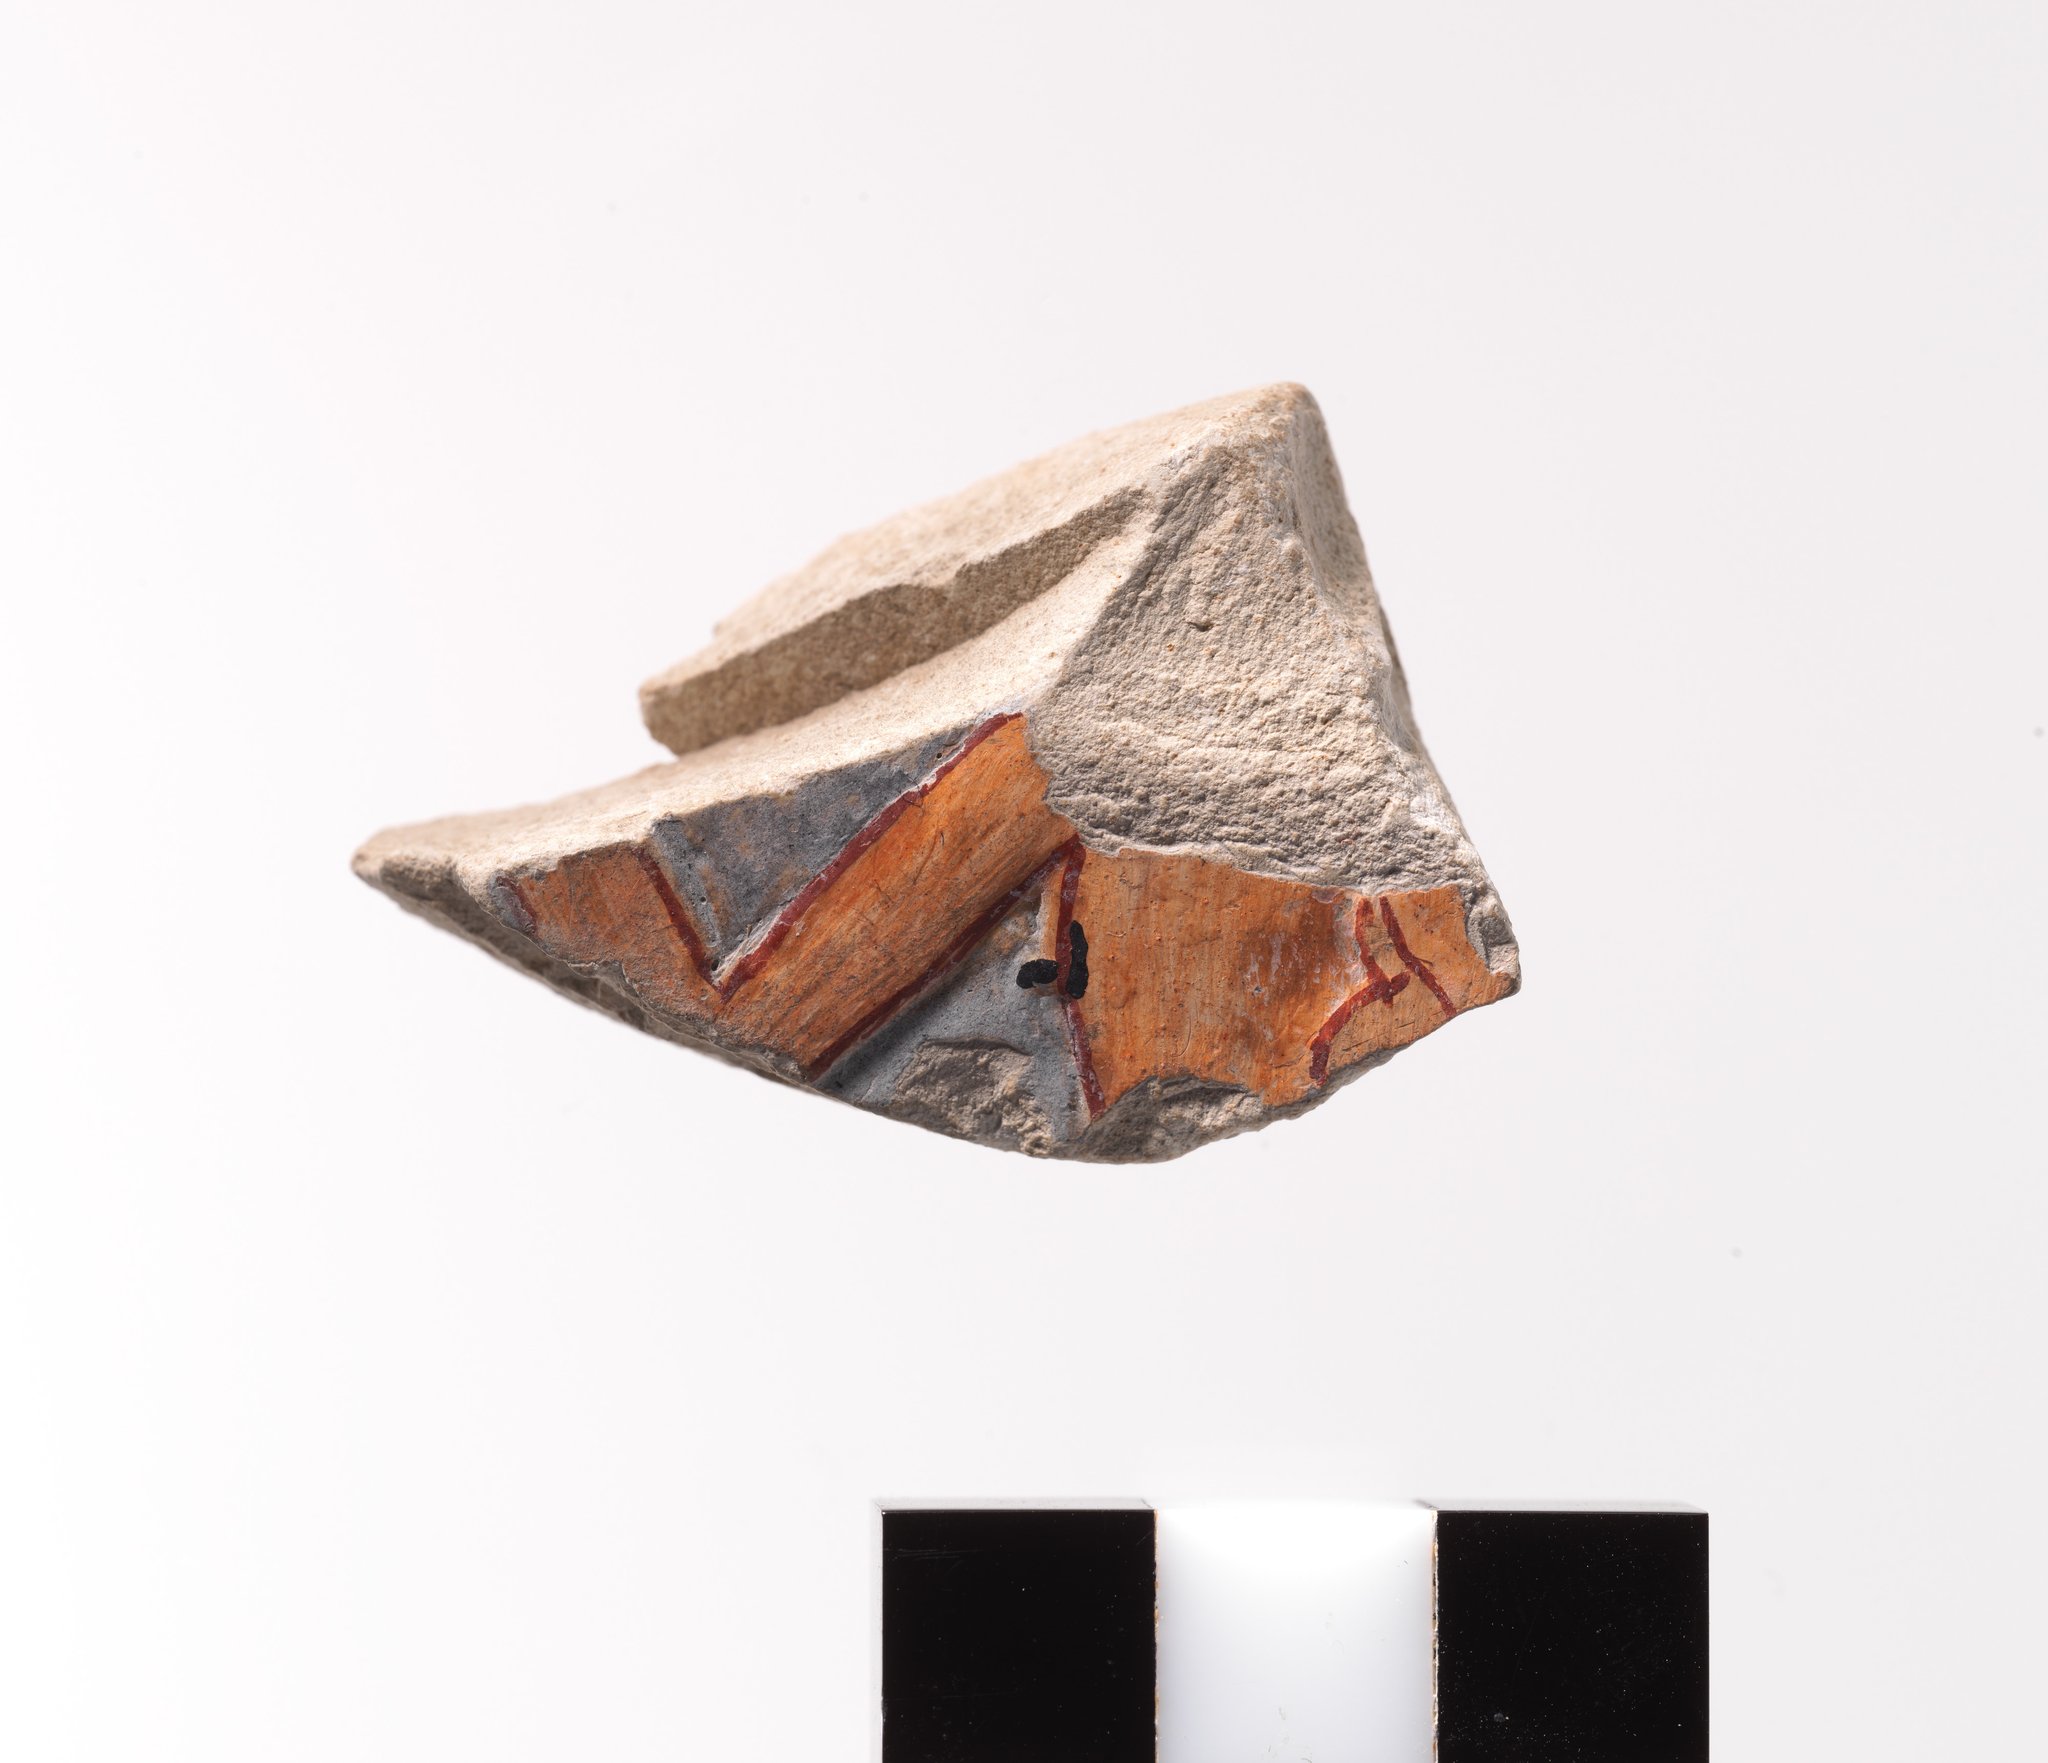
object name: relief fragment, tomb of meketre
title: Relief Fragment with Part of a Hieroglyph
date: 1981-1975 BCE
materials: limestone, paint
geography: egypt